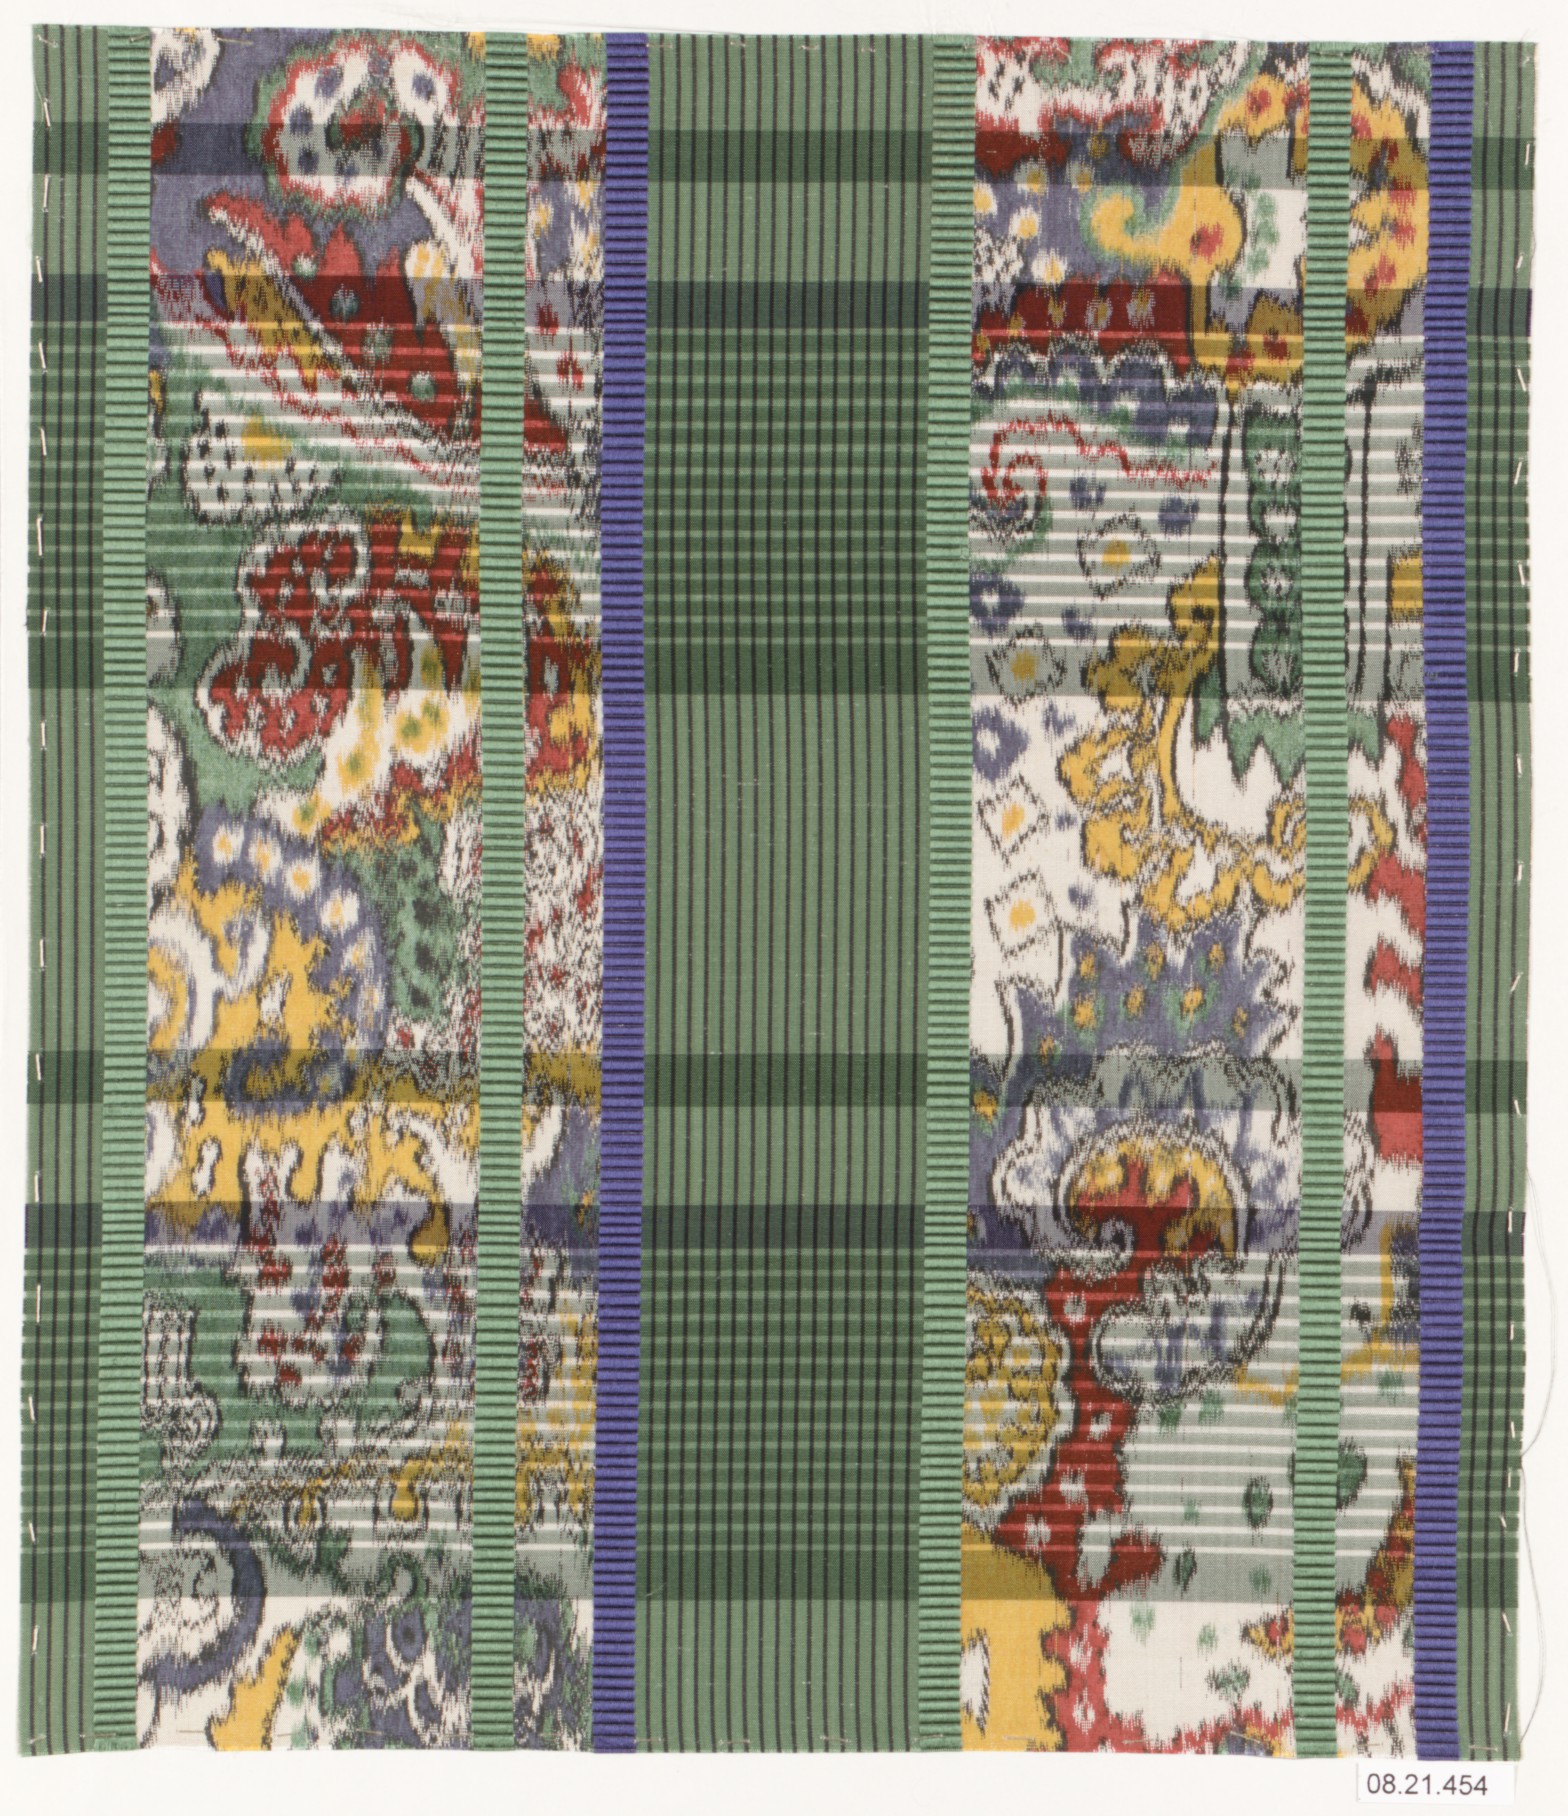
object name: textile sample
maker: Anonymous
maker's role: designer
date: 1900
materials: silk